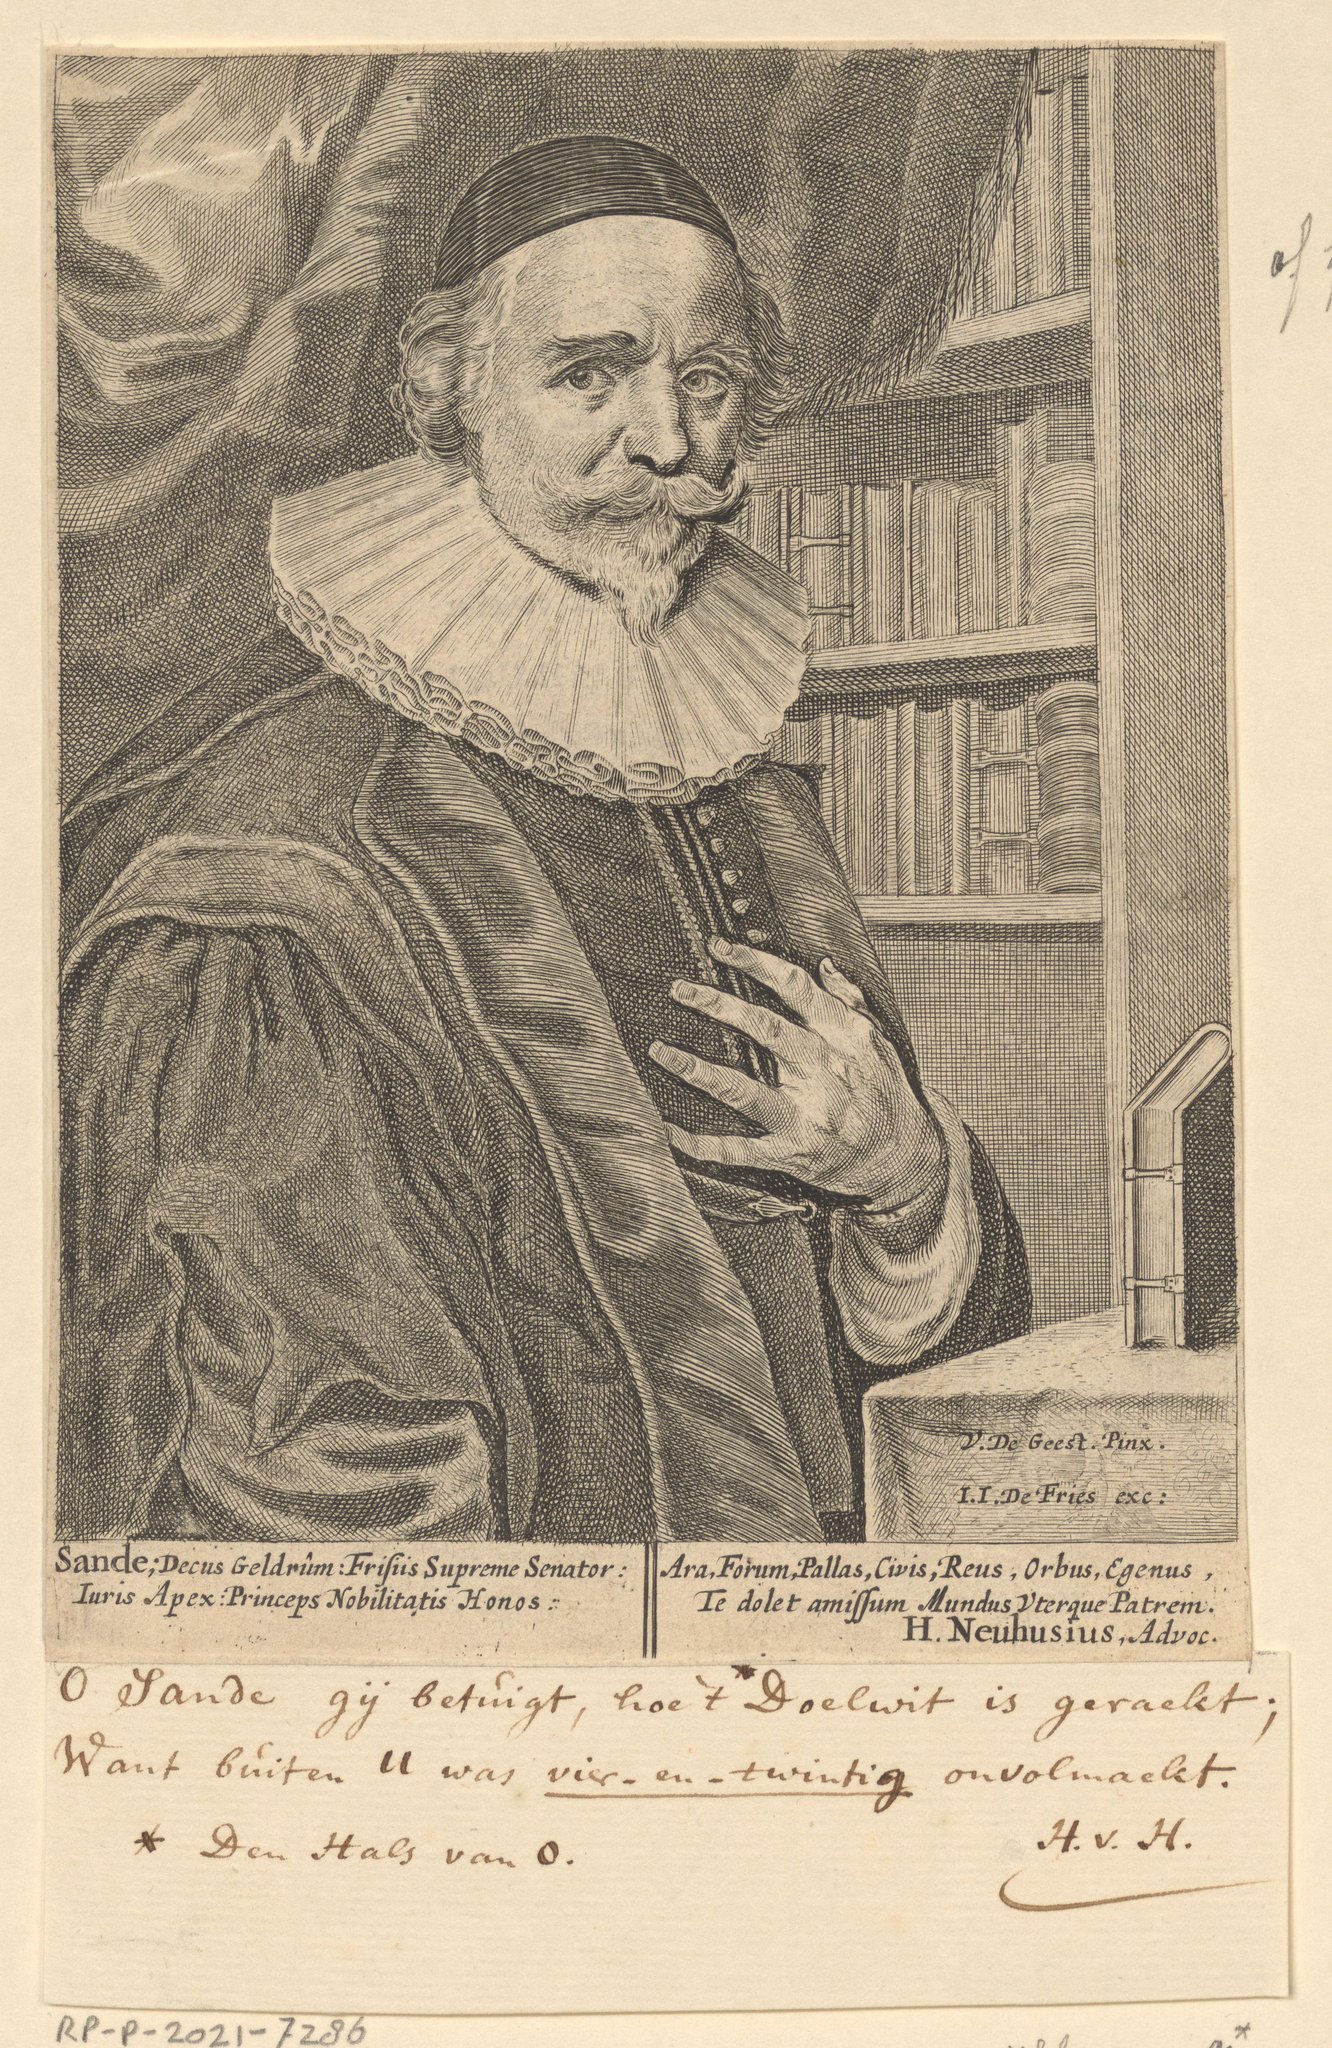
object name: print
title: Portret van Johan van den Sande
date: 1639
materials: paper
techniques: engraving, letterpress printing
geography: leeuwarden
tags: arnhem, johan van den sande, historical persons, portrait of a writer, book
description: Prent gebruikt in andere editie van: Sande, Johan van den. Decisiones Frisicae, sive rerum in suprema Frisiorum Curia judicatarum (...). Leeuwarden: Johannes Jansonius, 1639, dl. 5.